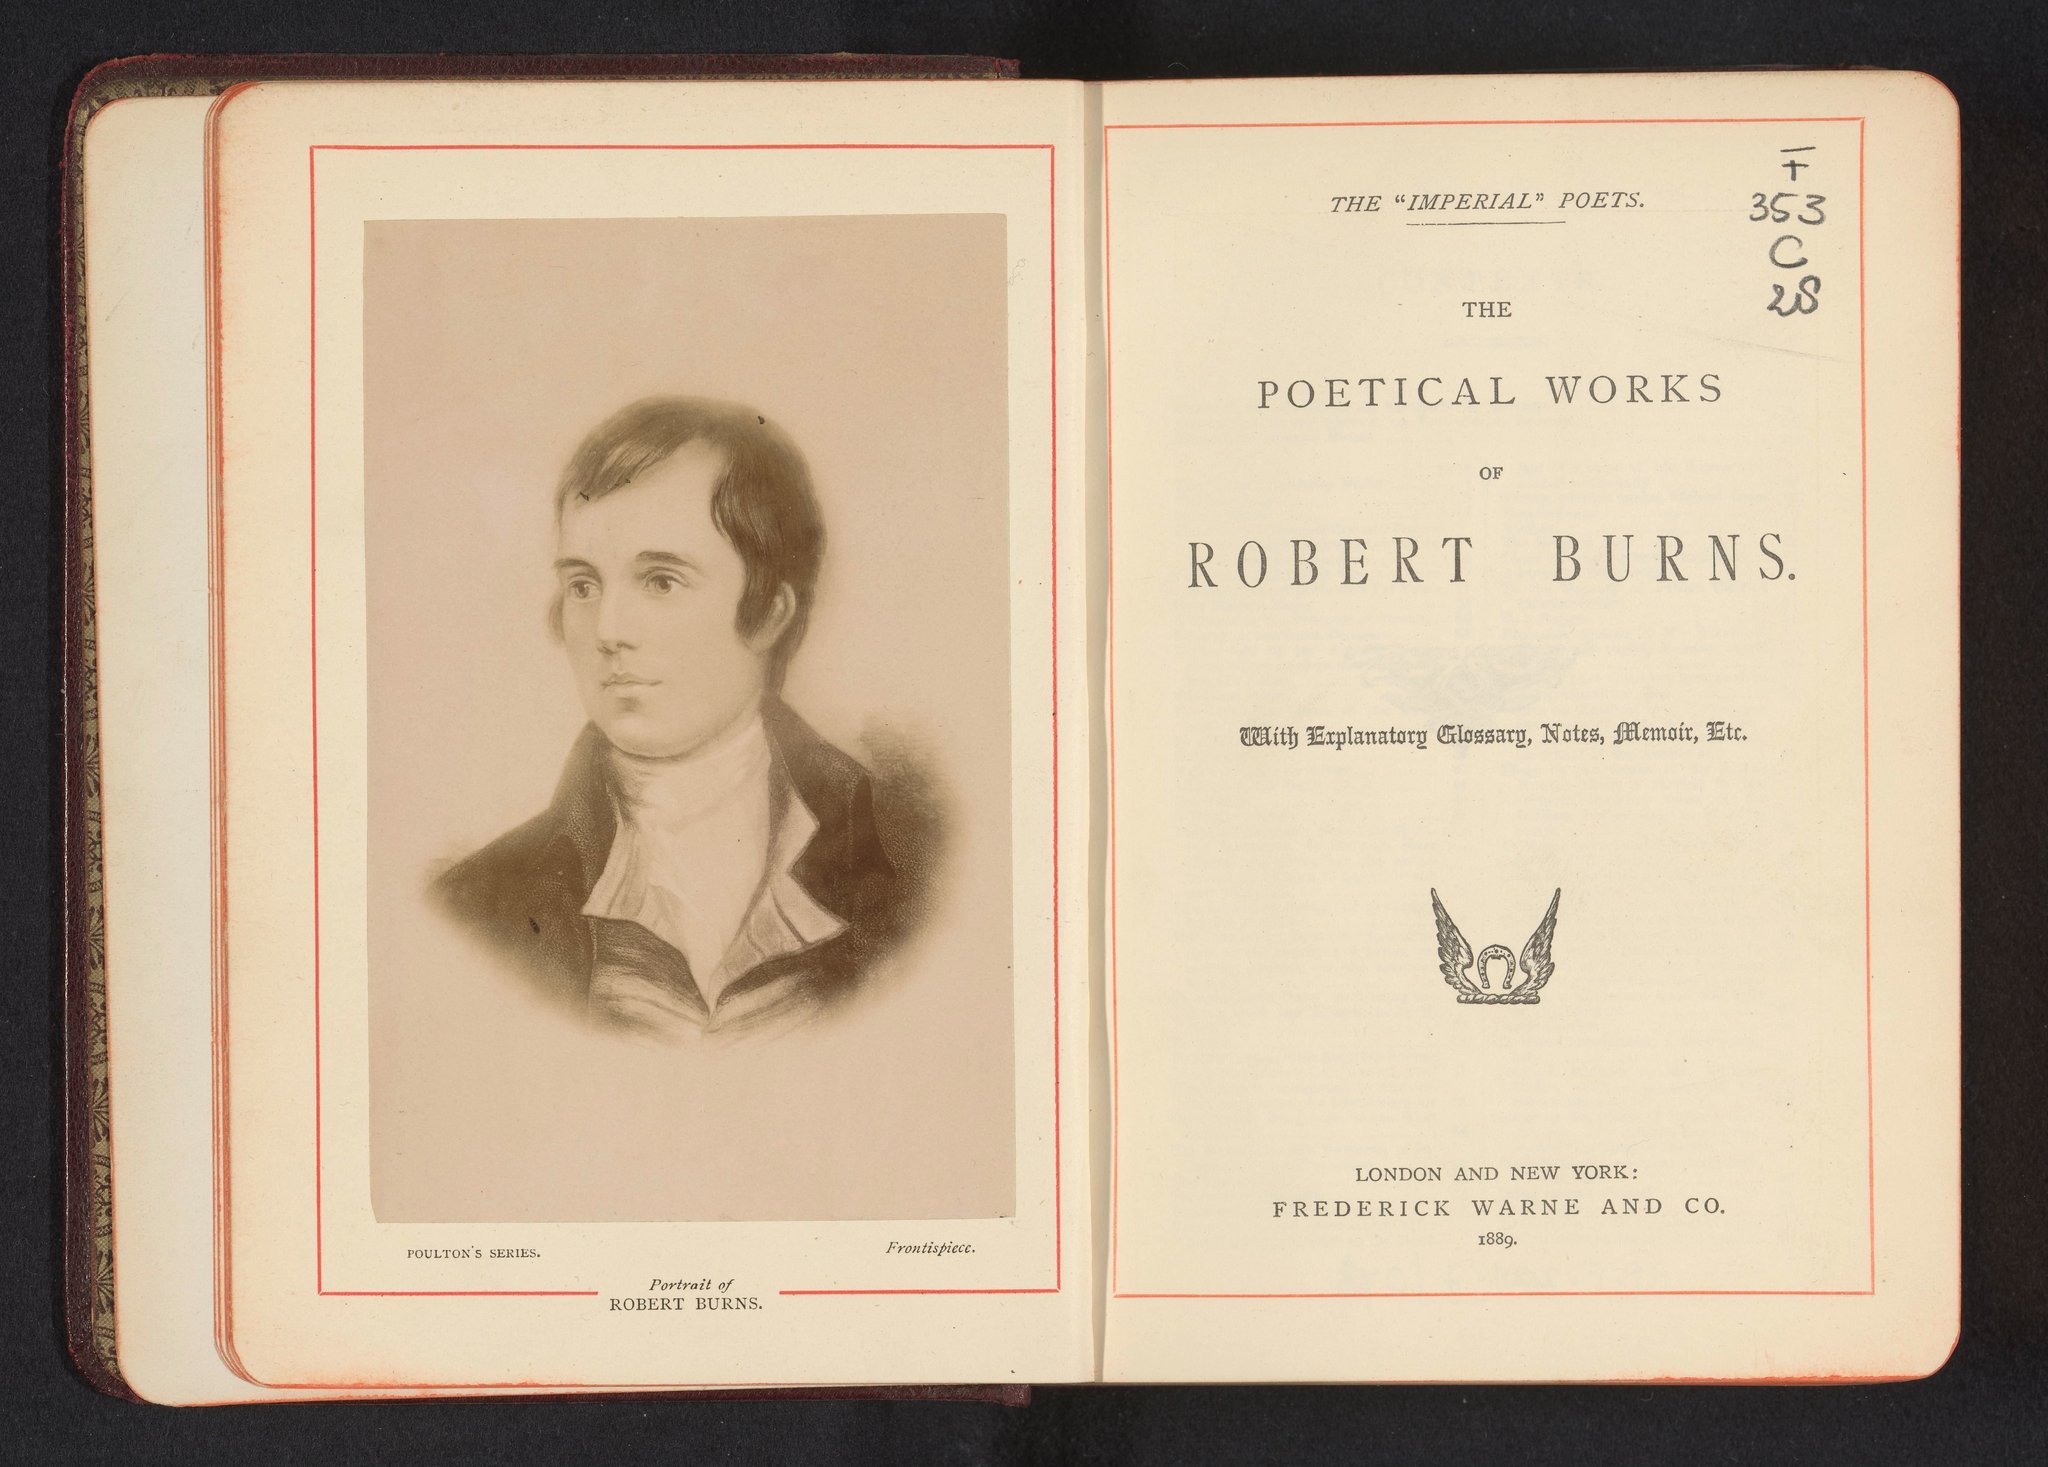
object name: book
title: The poetical works of Robert Burns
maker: robert burns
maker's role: dichter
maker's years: 1759-1796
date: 1889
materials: cardboard, leather, paper, photographic support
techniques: albumen print, decorated paper, printing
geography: london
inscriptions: inscription: ‘J.A & N. Ltd. York house Regent Street London S.W.’